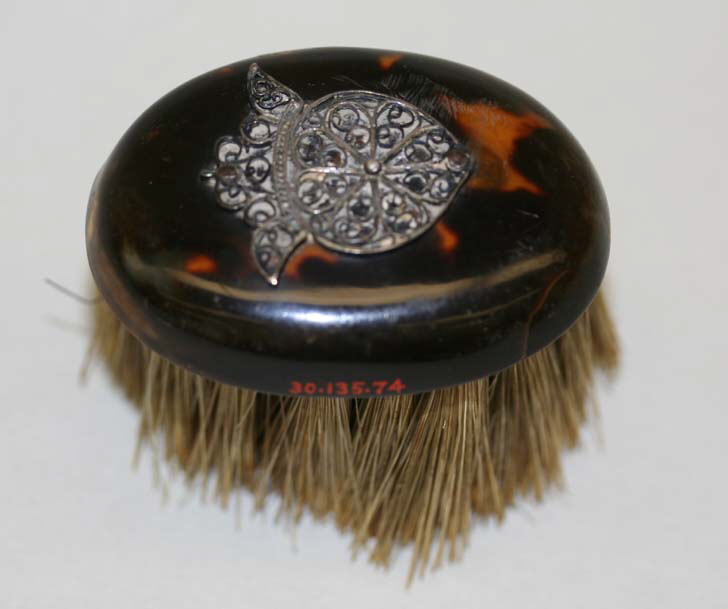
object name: brush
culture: french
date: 1601-1700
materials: shell